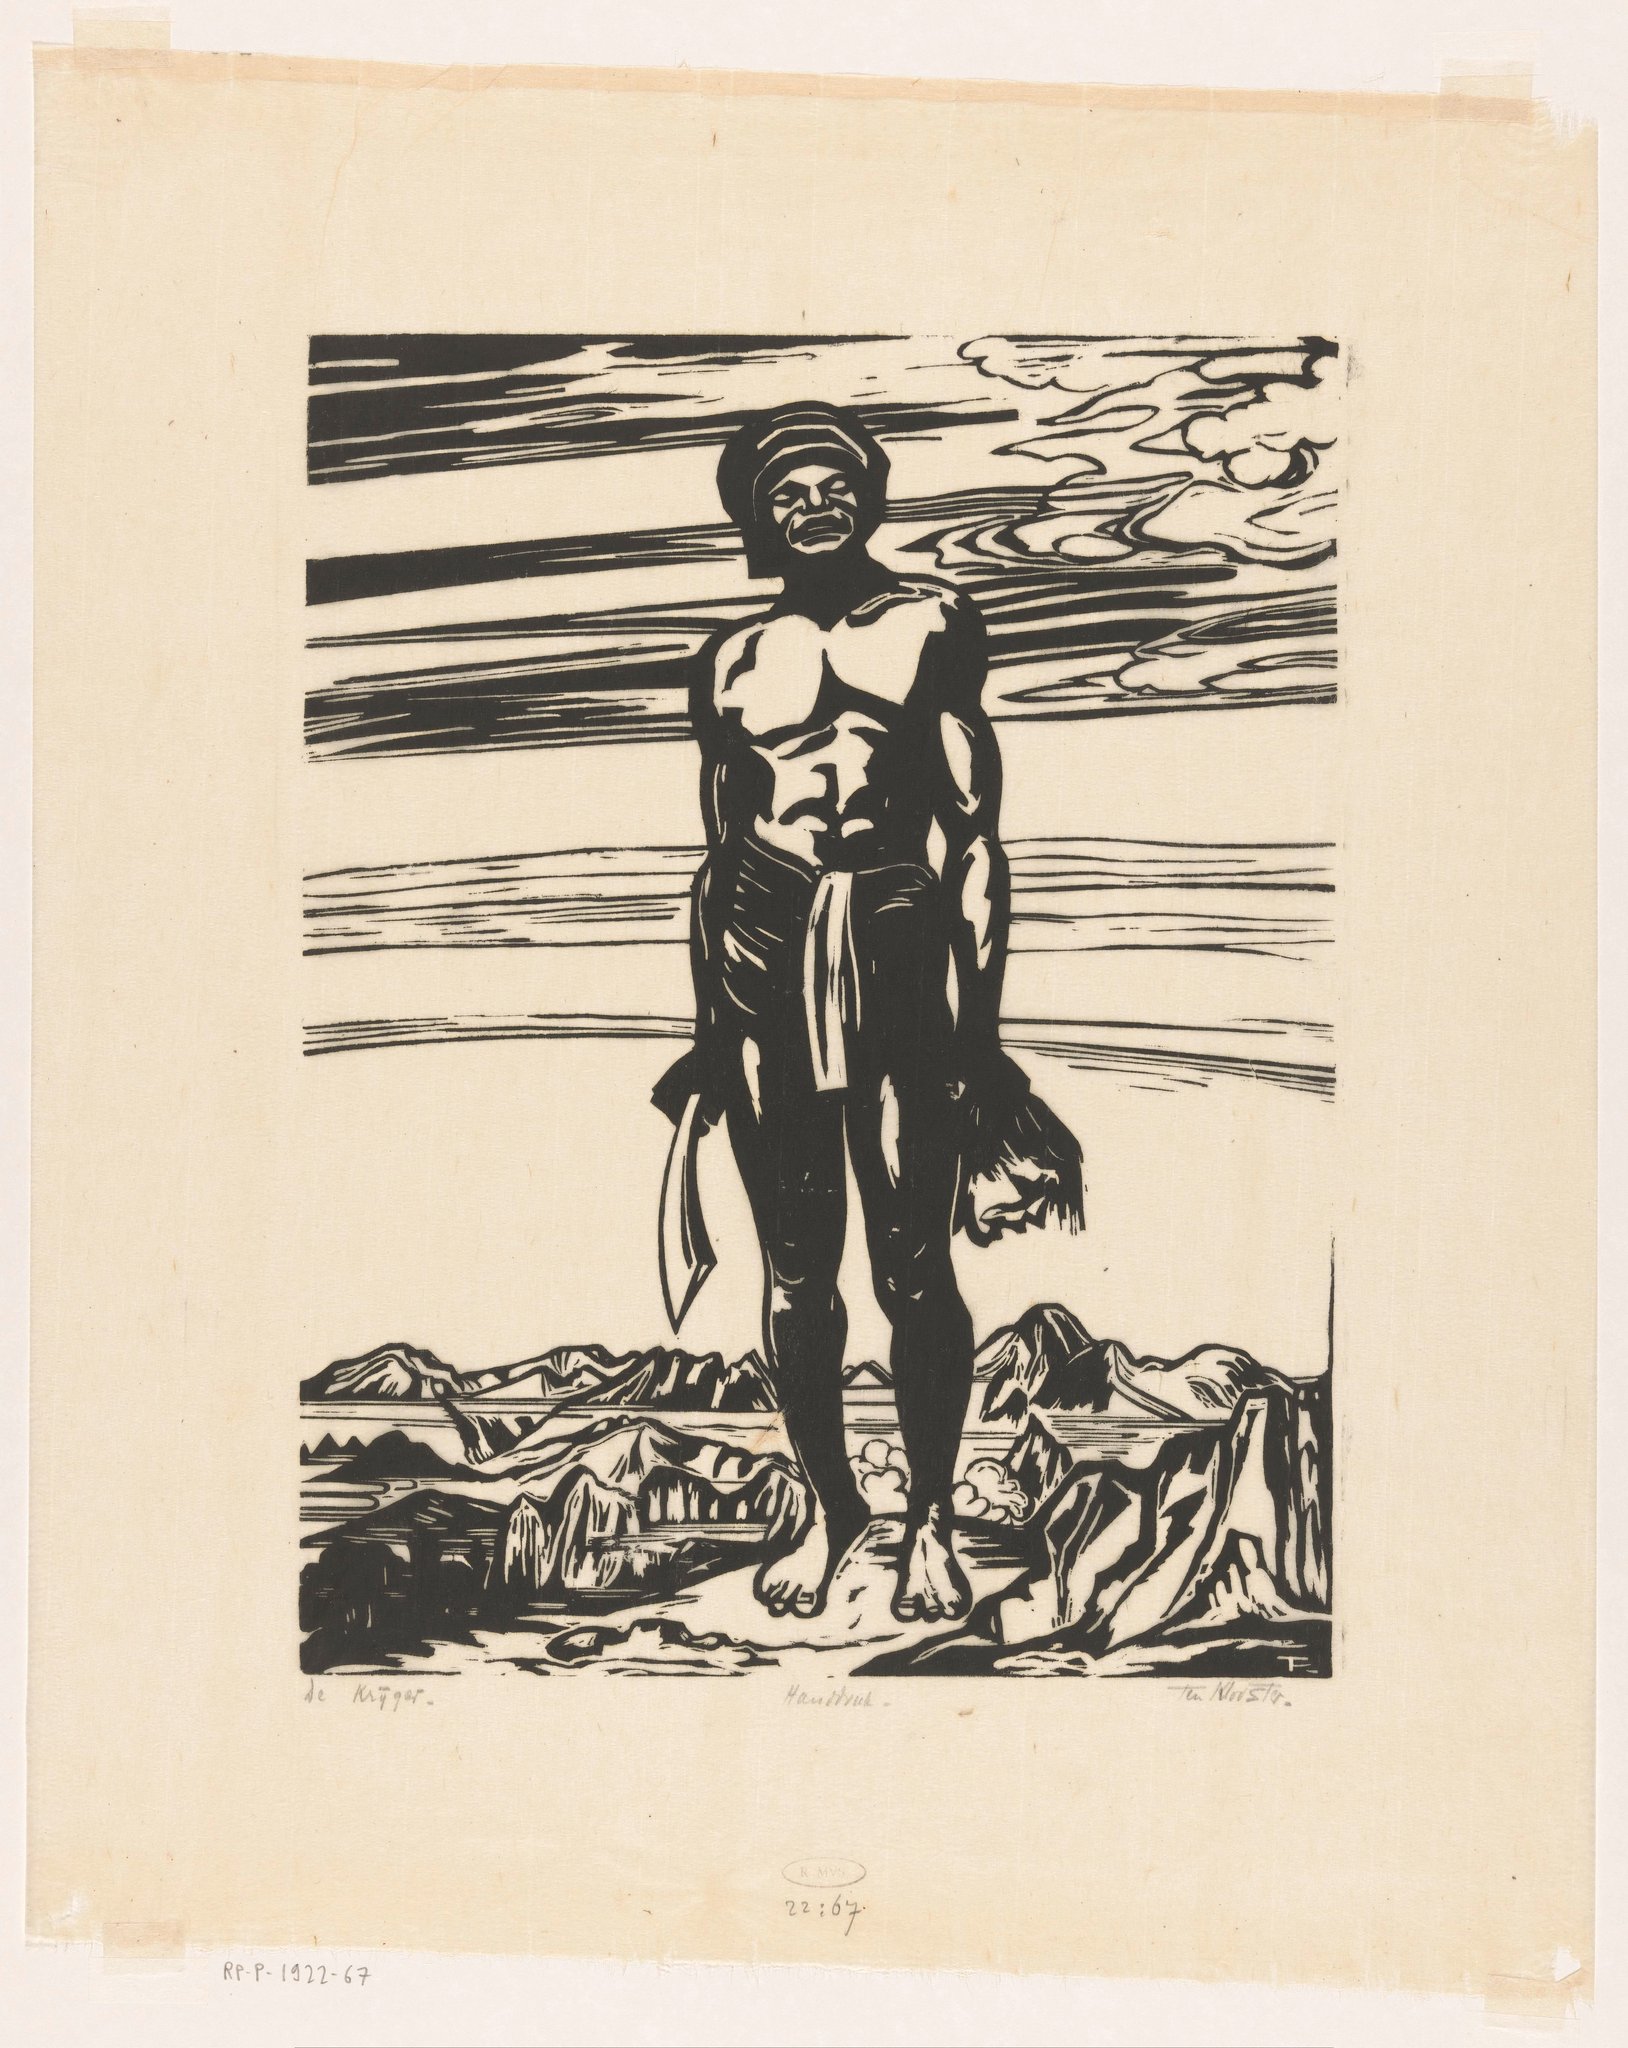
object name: print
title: De krijger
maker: johannes frederik engelbert ten klooster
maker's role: draughtsman, print maker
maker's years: 1873-1940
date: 1920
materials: paper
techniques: woodcut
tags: partially clothed, hacking and thrusting weapons, head of a beheaded person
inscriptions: collector's mark: Lugt 2228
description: Een halfnaakte man in lendendoek, staand in een rotsachtig landschap. In zijn rechterhand een sabel, in zijn linkerhand een afgehouwen hoofd.